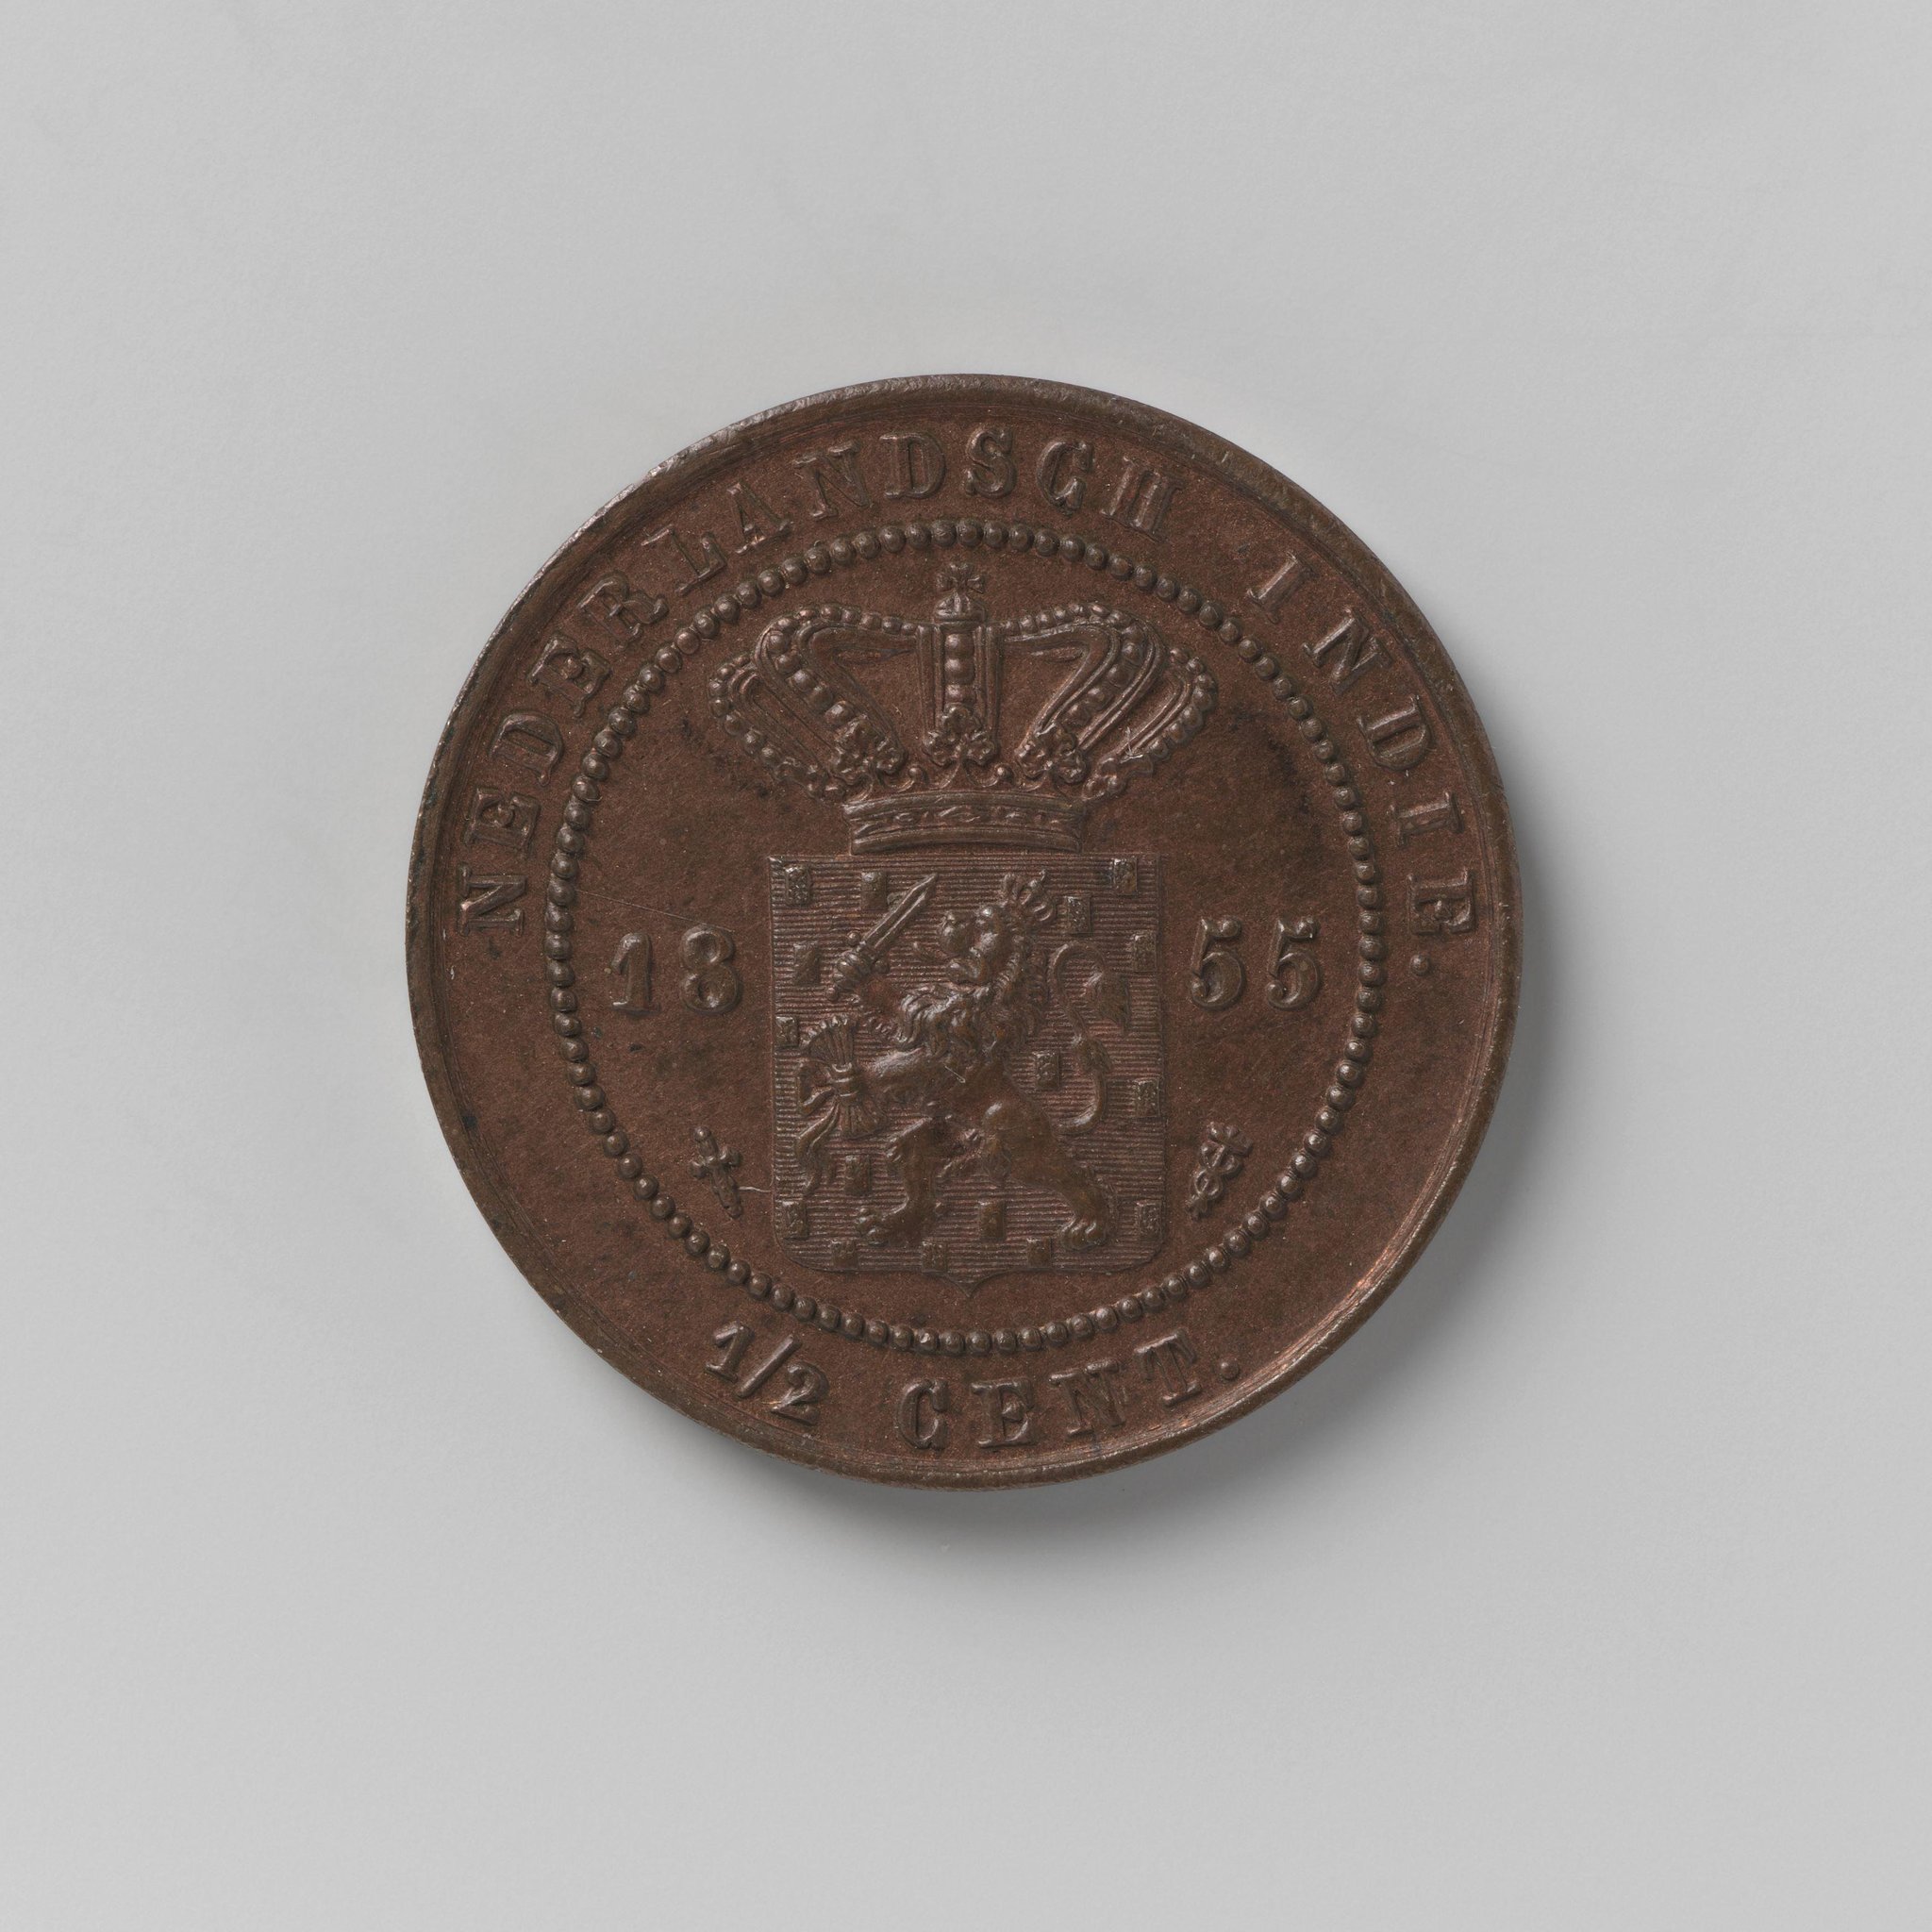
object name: coin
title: Nederlands Indië, ½ cent, 1855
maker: willem iii (koning der nederlanden)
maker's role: koning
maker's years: 1817-1890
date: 1855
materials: copper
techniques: striking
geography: utrecht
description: Koperen munt. Voorzijde: tussen jaartal gekroond rijkswapenschild. Boven kroon landsaanduiding en onder wapenschild waarde-aanduiding. Keerzijde: drieregelig Maleis opschrift in Arabische tekens, waaromheen omschrift in het Javaans. Gladde rand.